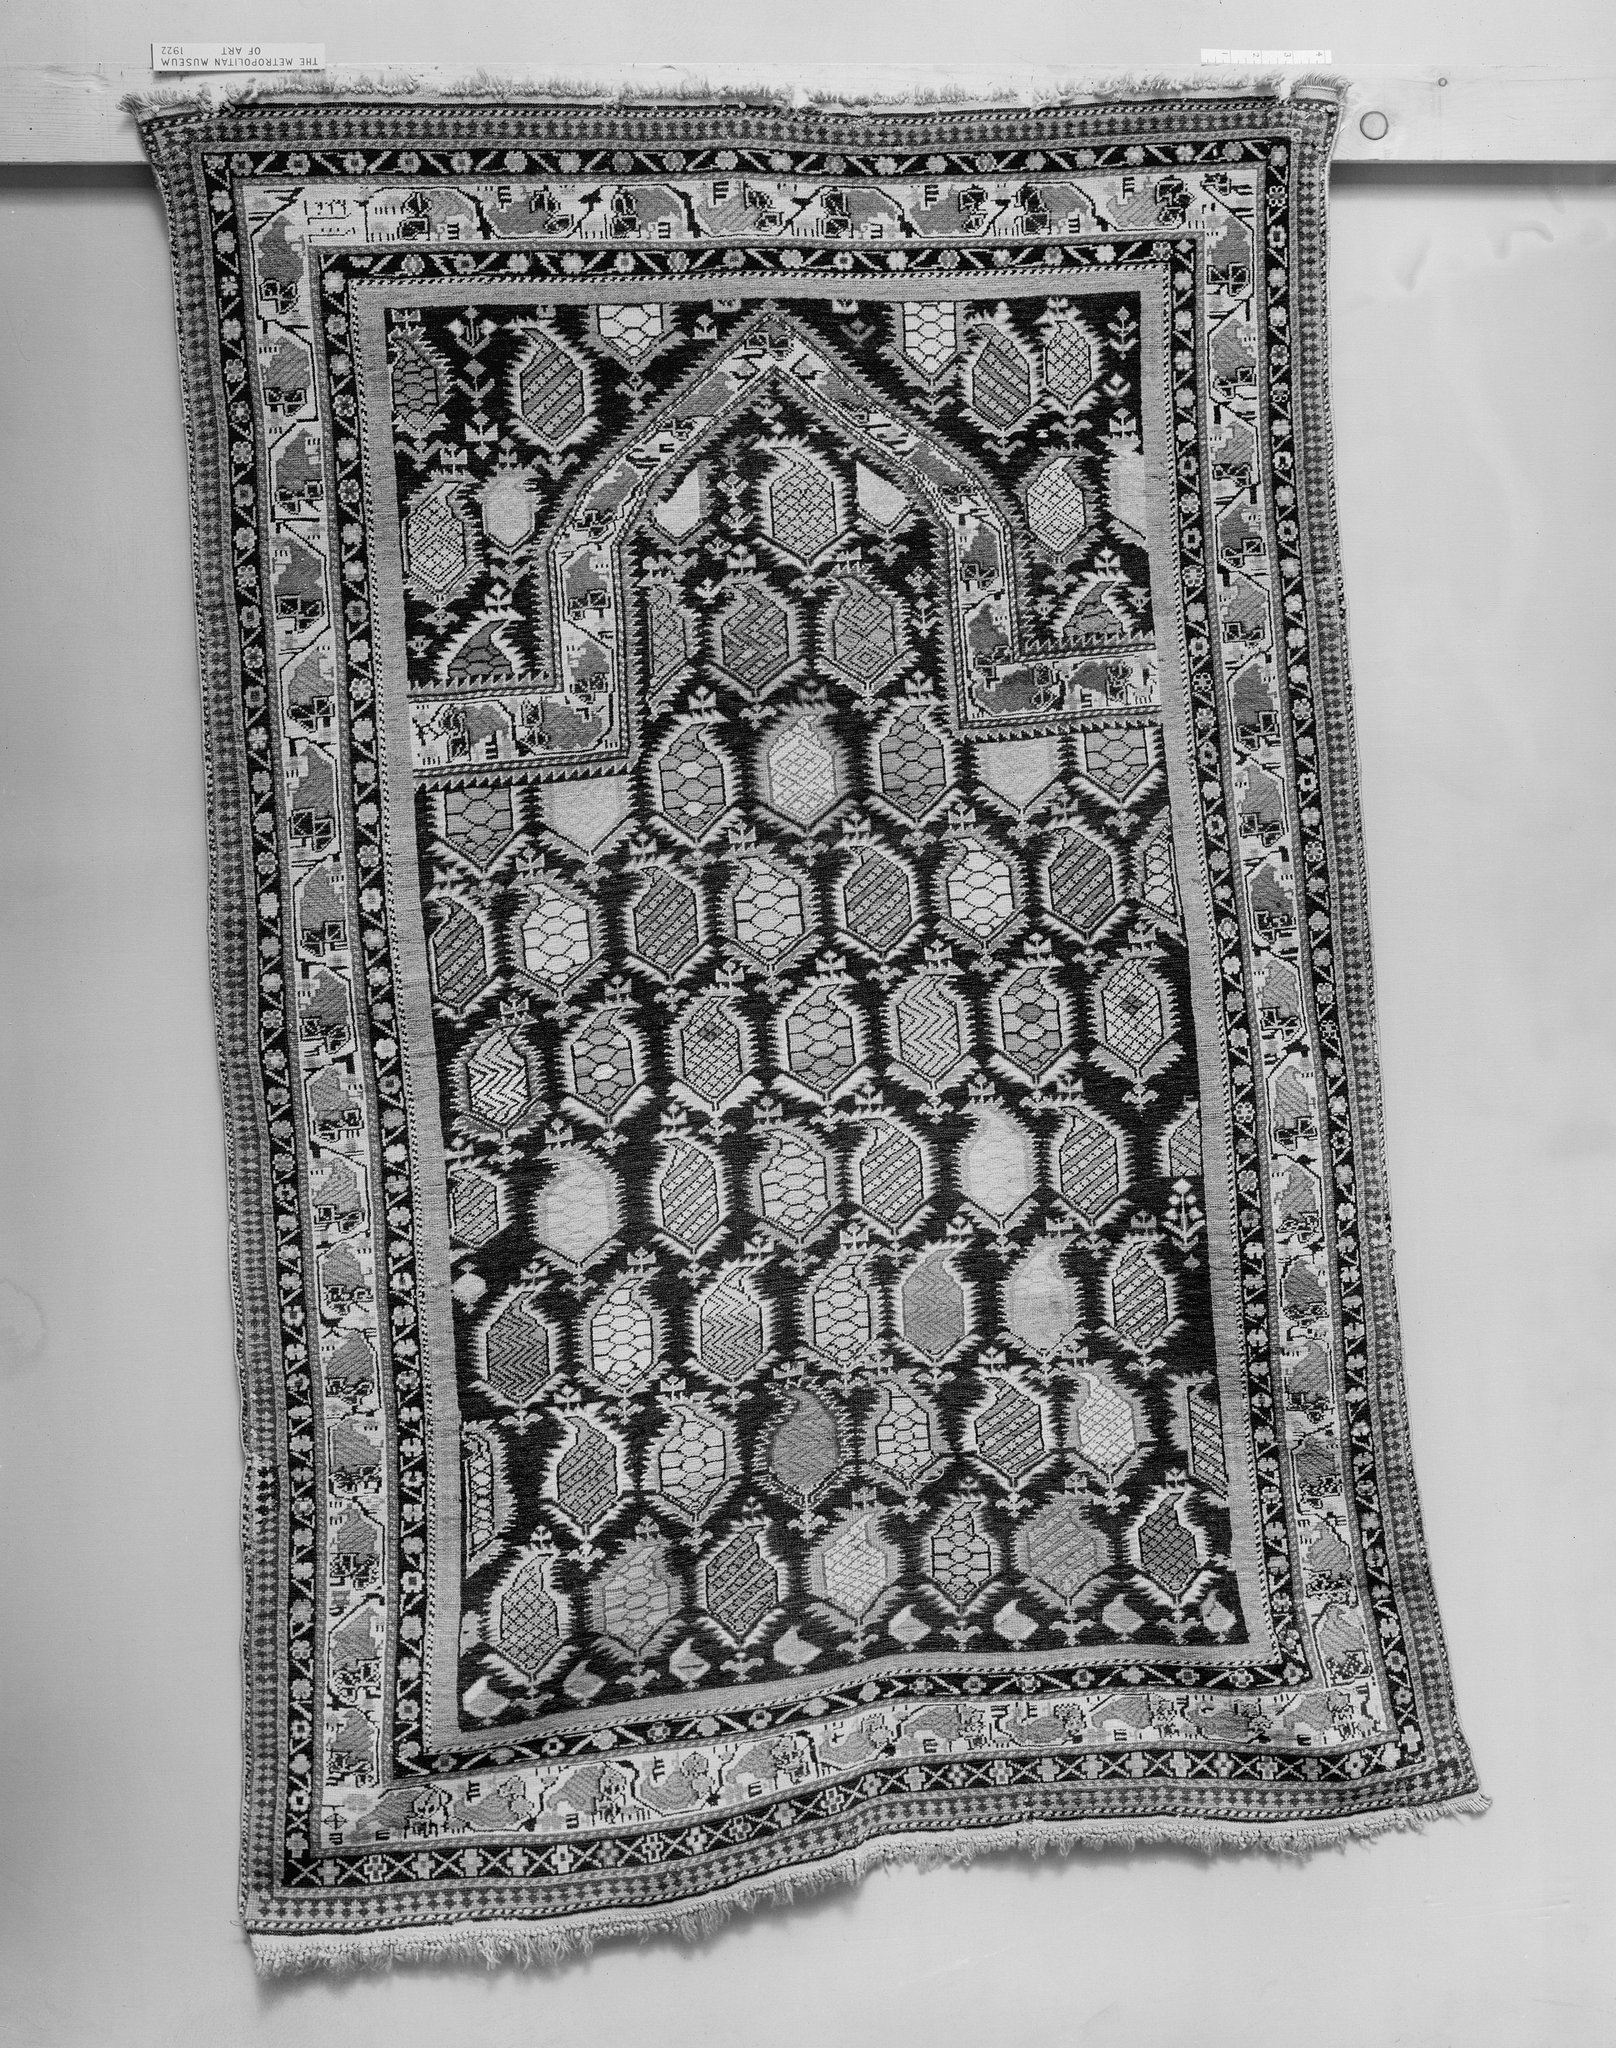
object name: carpet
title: "Marasali" Shirvan Prayer Rug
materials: wool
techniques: pile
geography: azerbaijan